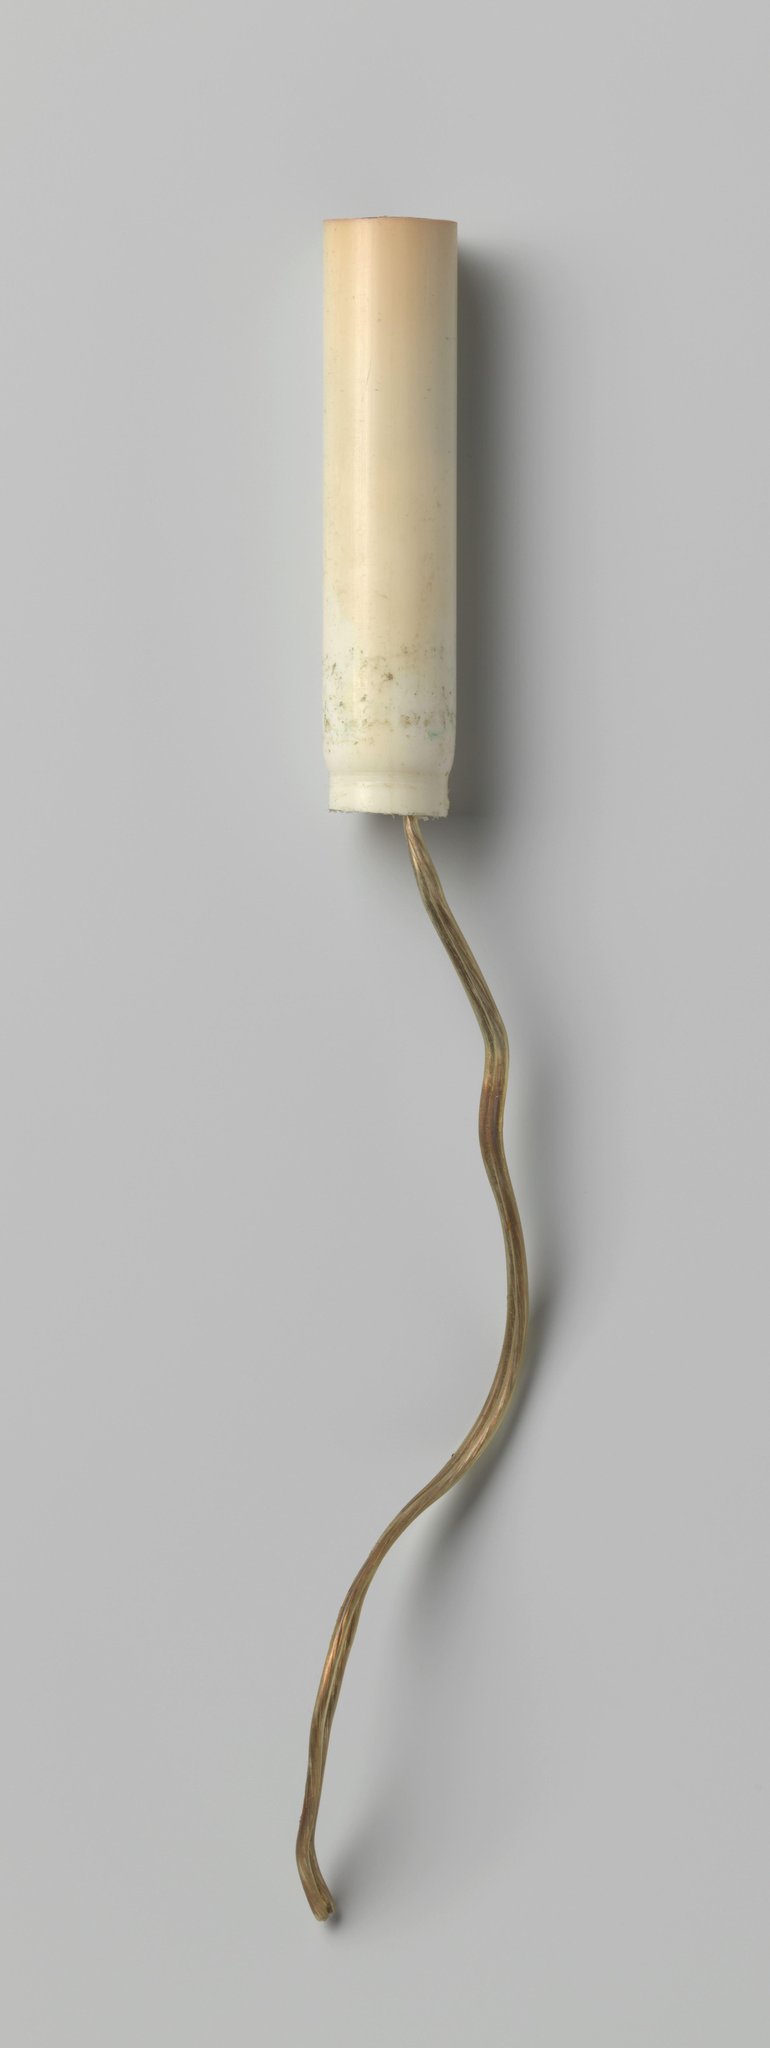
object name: lighting device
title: Fitting in kaarsvorm met electriciteitsdraad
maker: Anonymous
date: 1750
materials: copper, plastic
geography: northern netherlands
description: Fitting is waarschijnlijk onderdeel geweest van de wandarm.